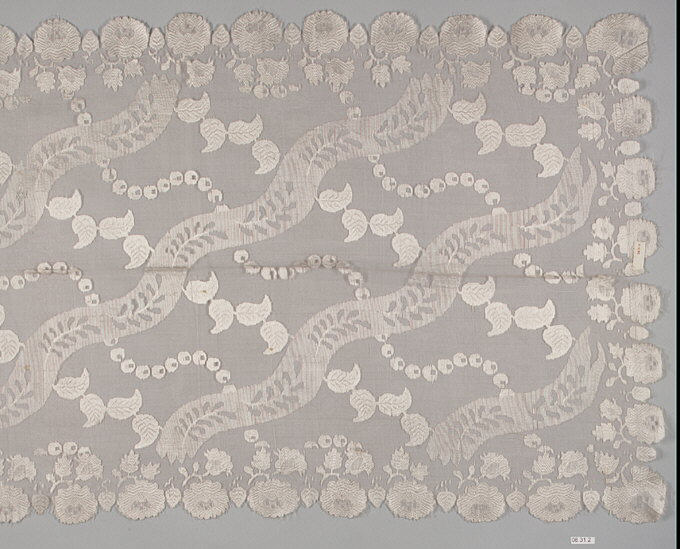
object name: scarf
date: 1867-1900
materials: lace